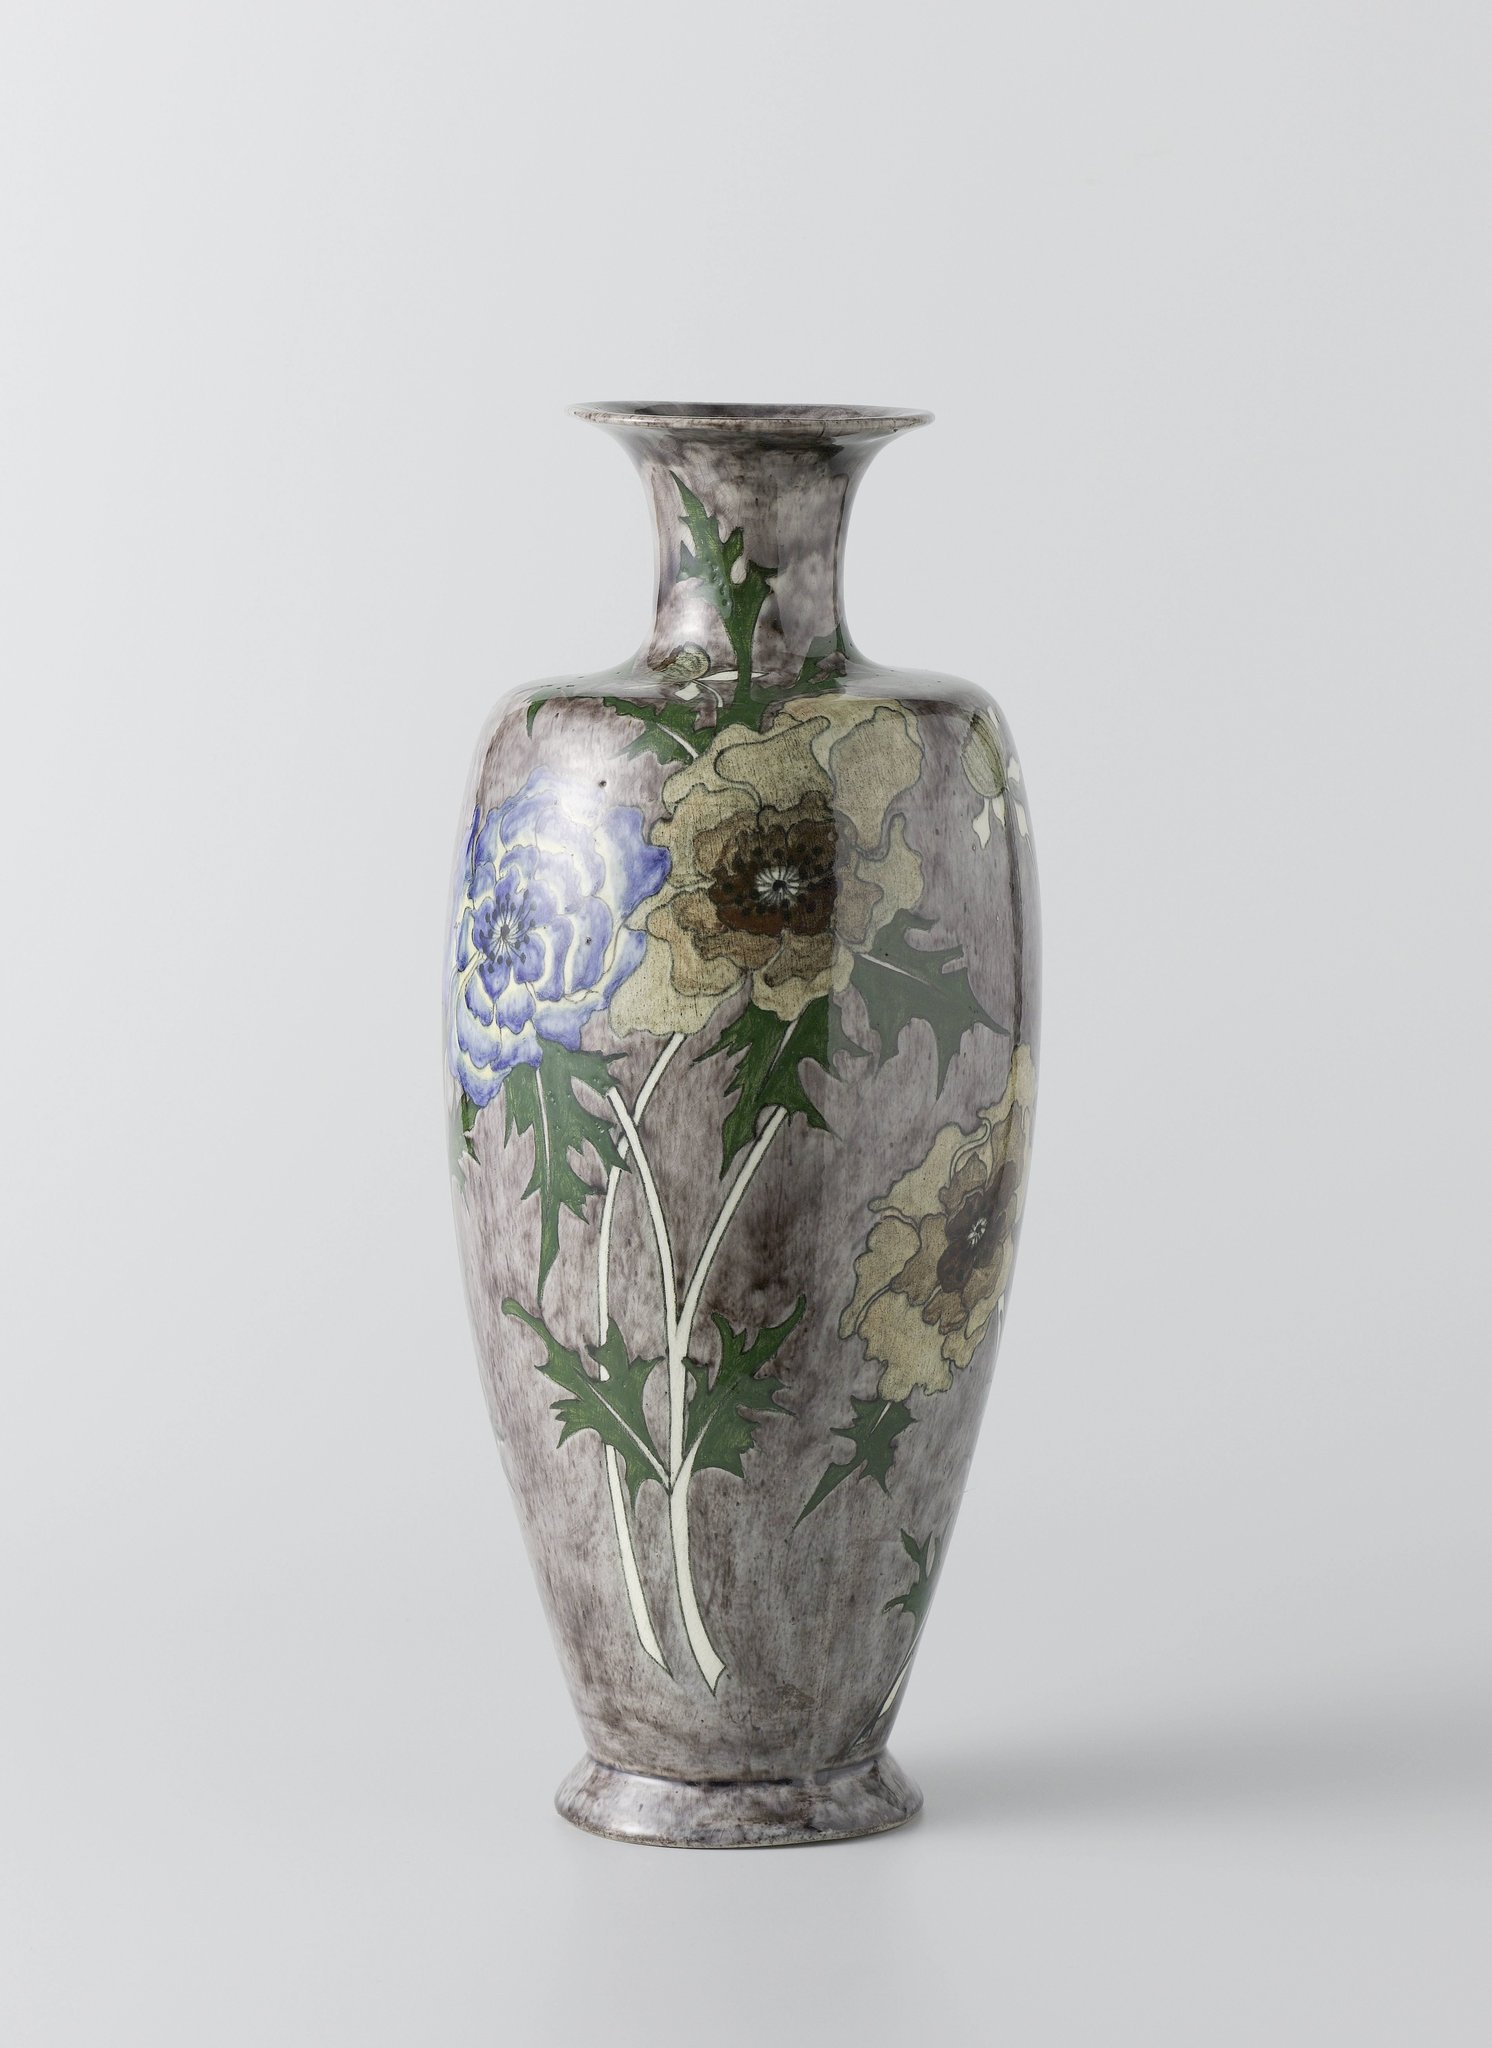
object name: vase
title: Vaas met beschildering van bloemen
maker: philippus lagrand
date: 1895-1904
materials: earthenware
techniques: painted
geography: purmerend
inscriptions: mark: ‘klomp / monogram / Faïence de Purmerende Hollande 500 Dec: C. monogram. E.’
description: Vase. Earthenware. Purmerend, c. 1900, made by Firma Wed. N.S.A. Brantjes, decorated by Hendrikus W. Dekkers, factory under the direction of the widow of N.S.A. Brantjes. Gift of Mr C.A. Burgers, 1979.